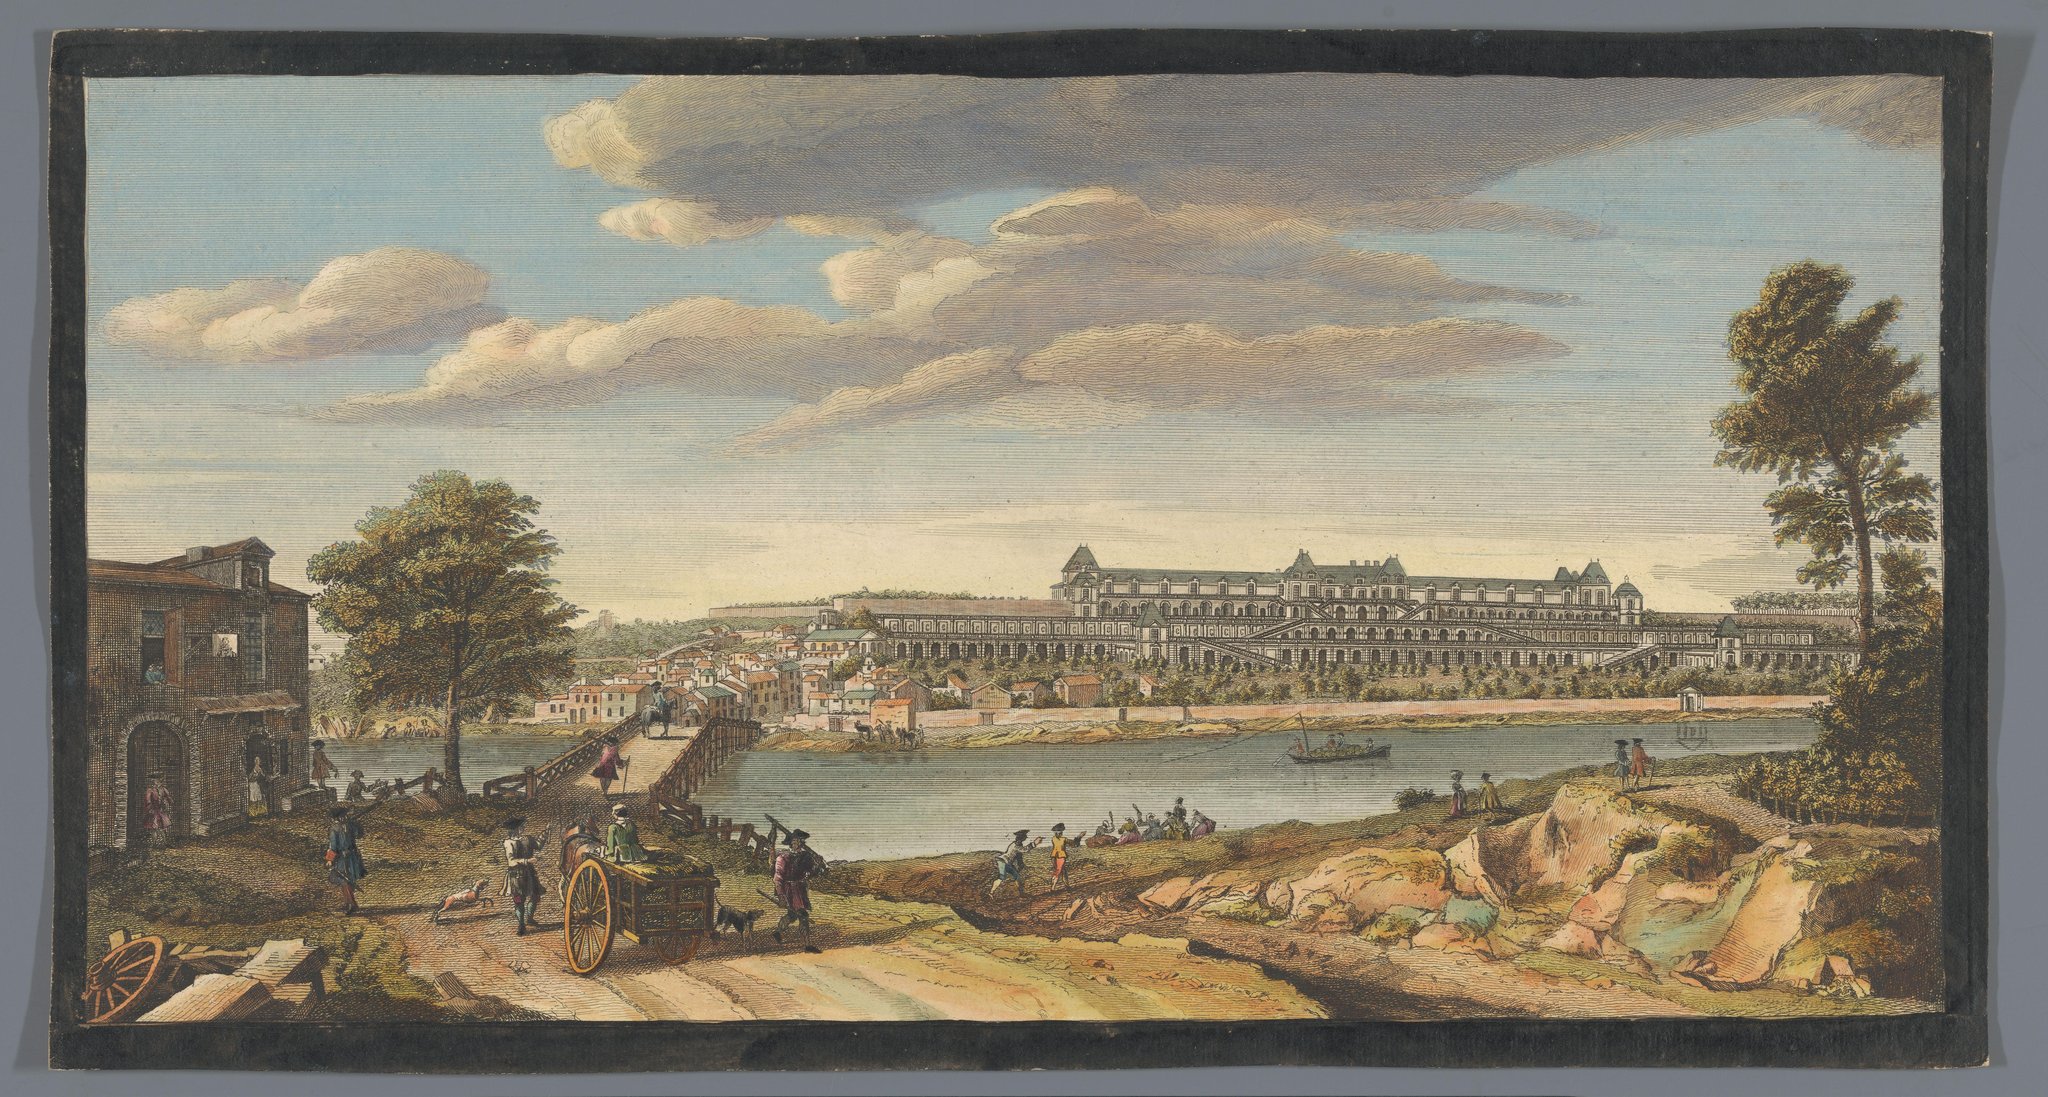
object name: opticaprent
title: Gezicht op het dorp Pecq en het Château de Saint-Germain-en-Laye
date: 1700-1761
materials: cardboard, paper, watercolor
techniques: brush, etching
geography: england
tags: village (+ city(-scape) with figures, staffage), civic architecture; edifices; dwellings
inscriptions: inscription: ‘Fo 25 B4’